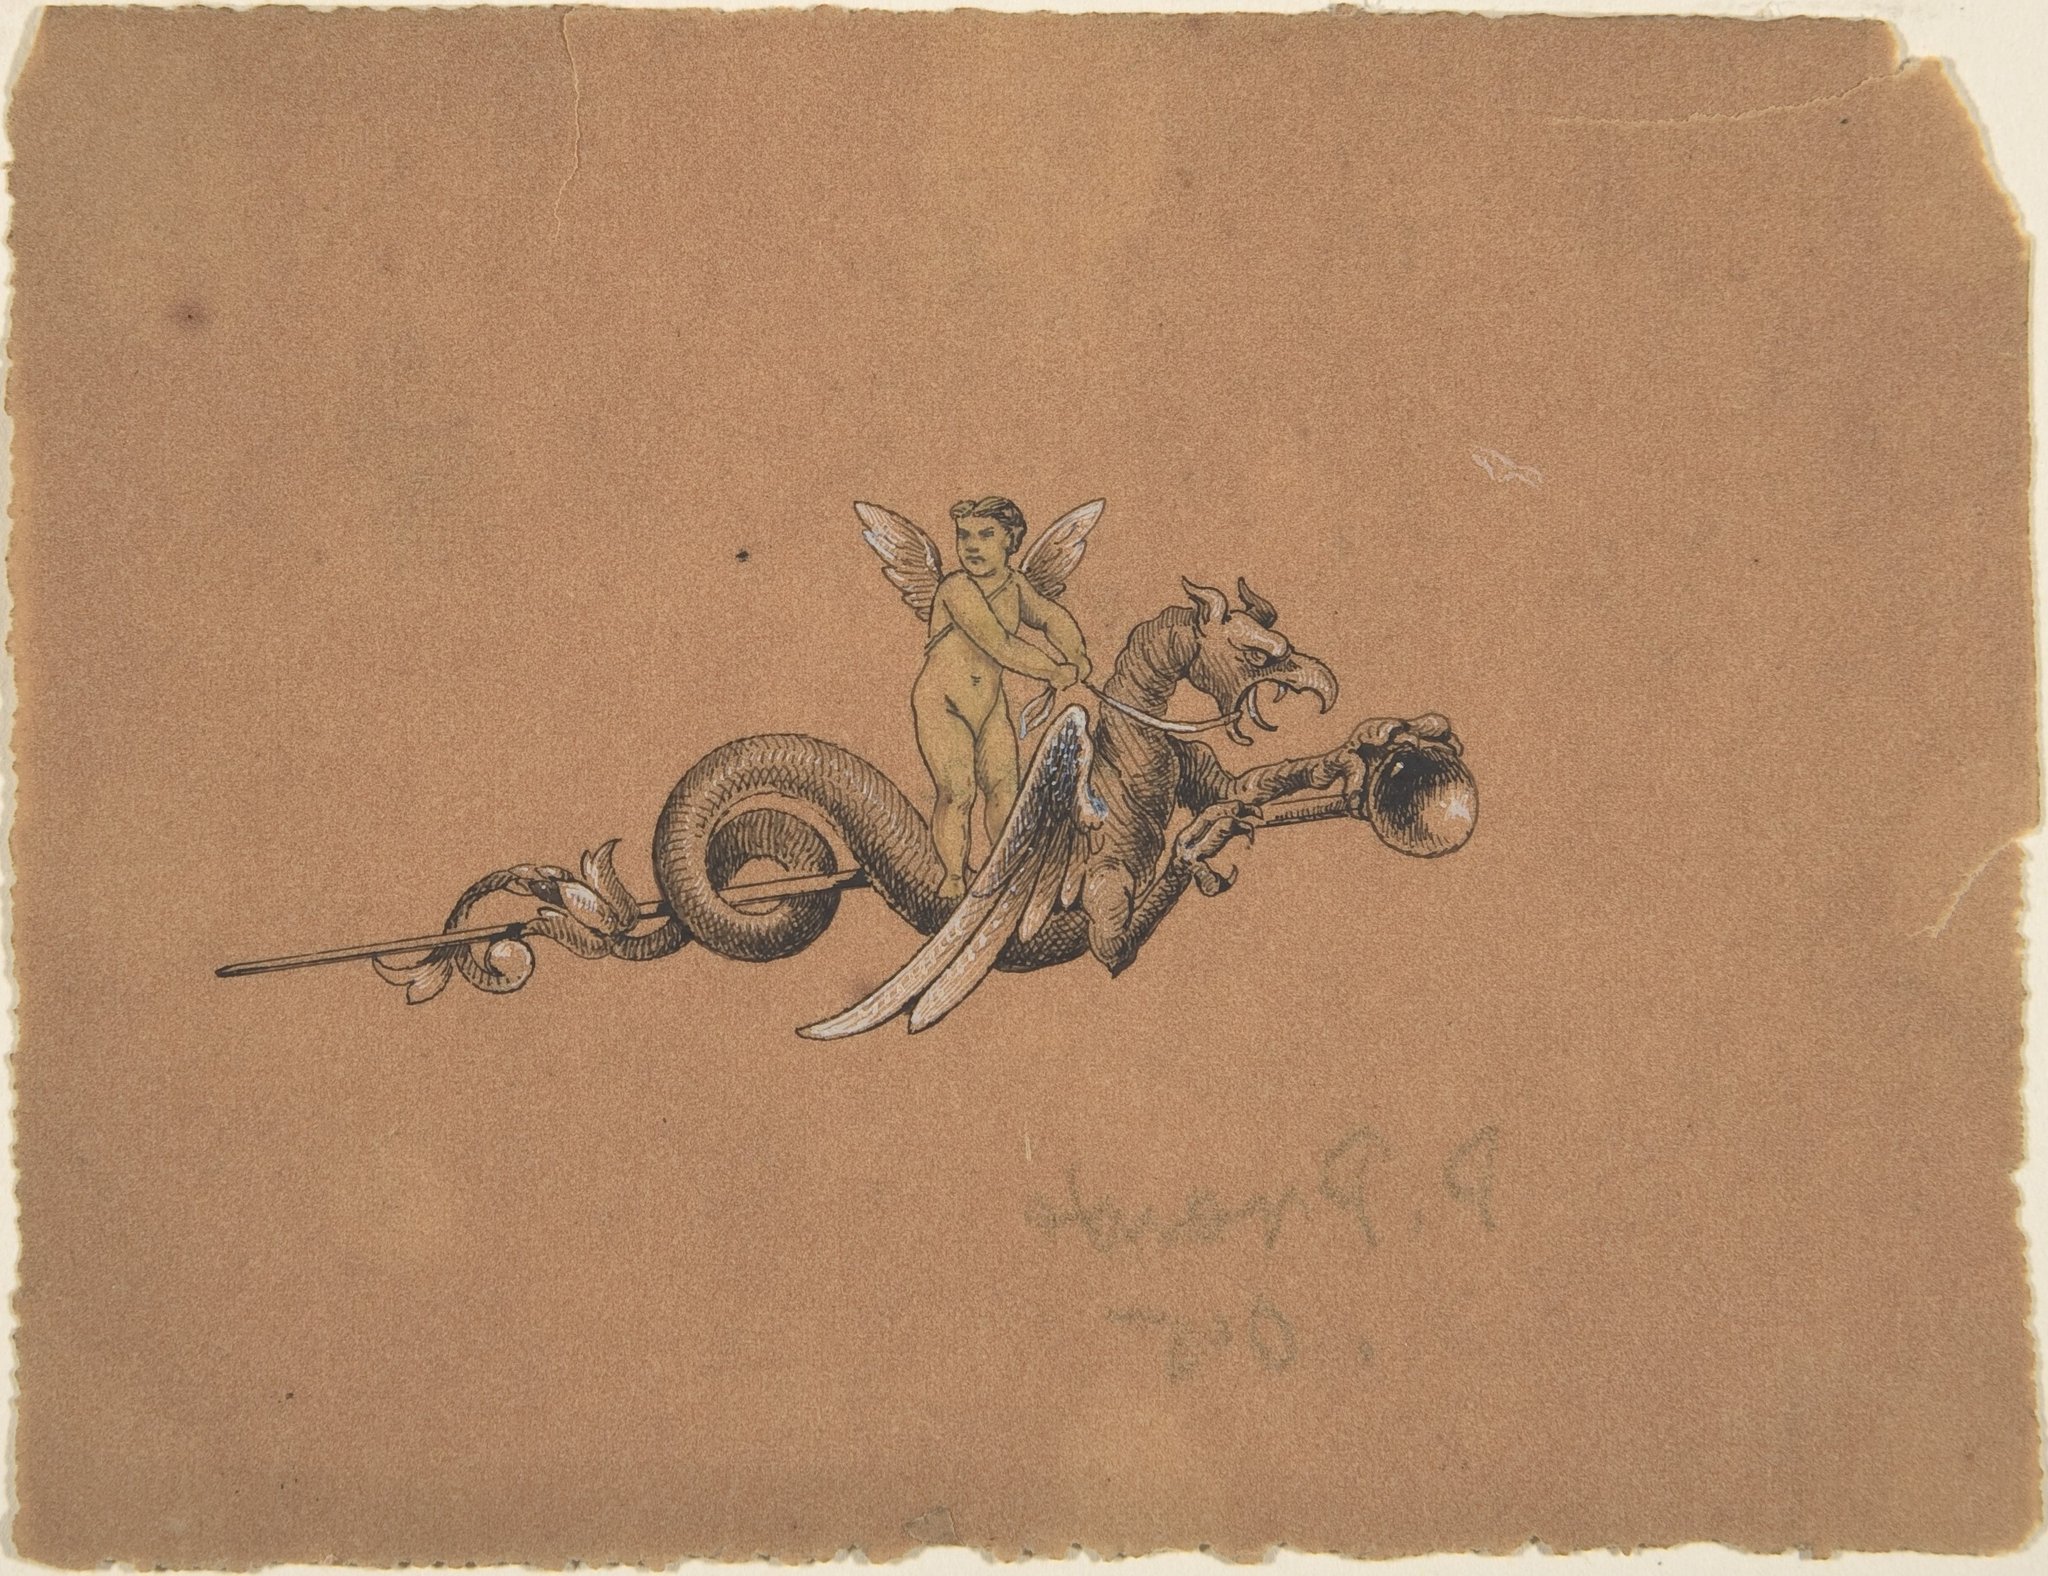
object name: drawing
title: Design for Jewelry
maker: anonymous, french, 19th century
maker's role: artist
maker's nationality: french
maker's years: 1800-1900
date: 1801-1900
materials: ink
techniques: brush, heightening, pen, wash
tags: jewelry,dragons